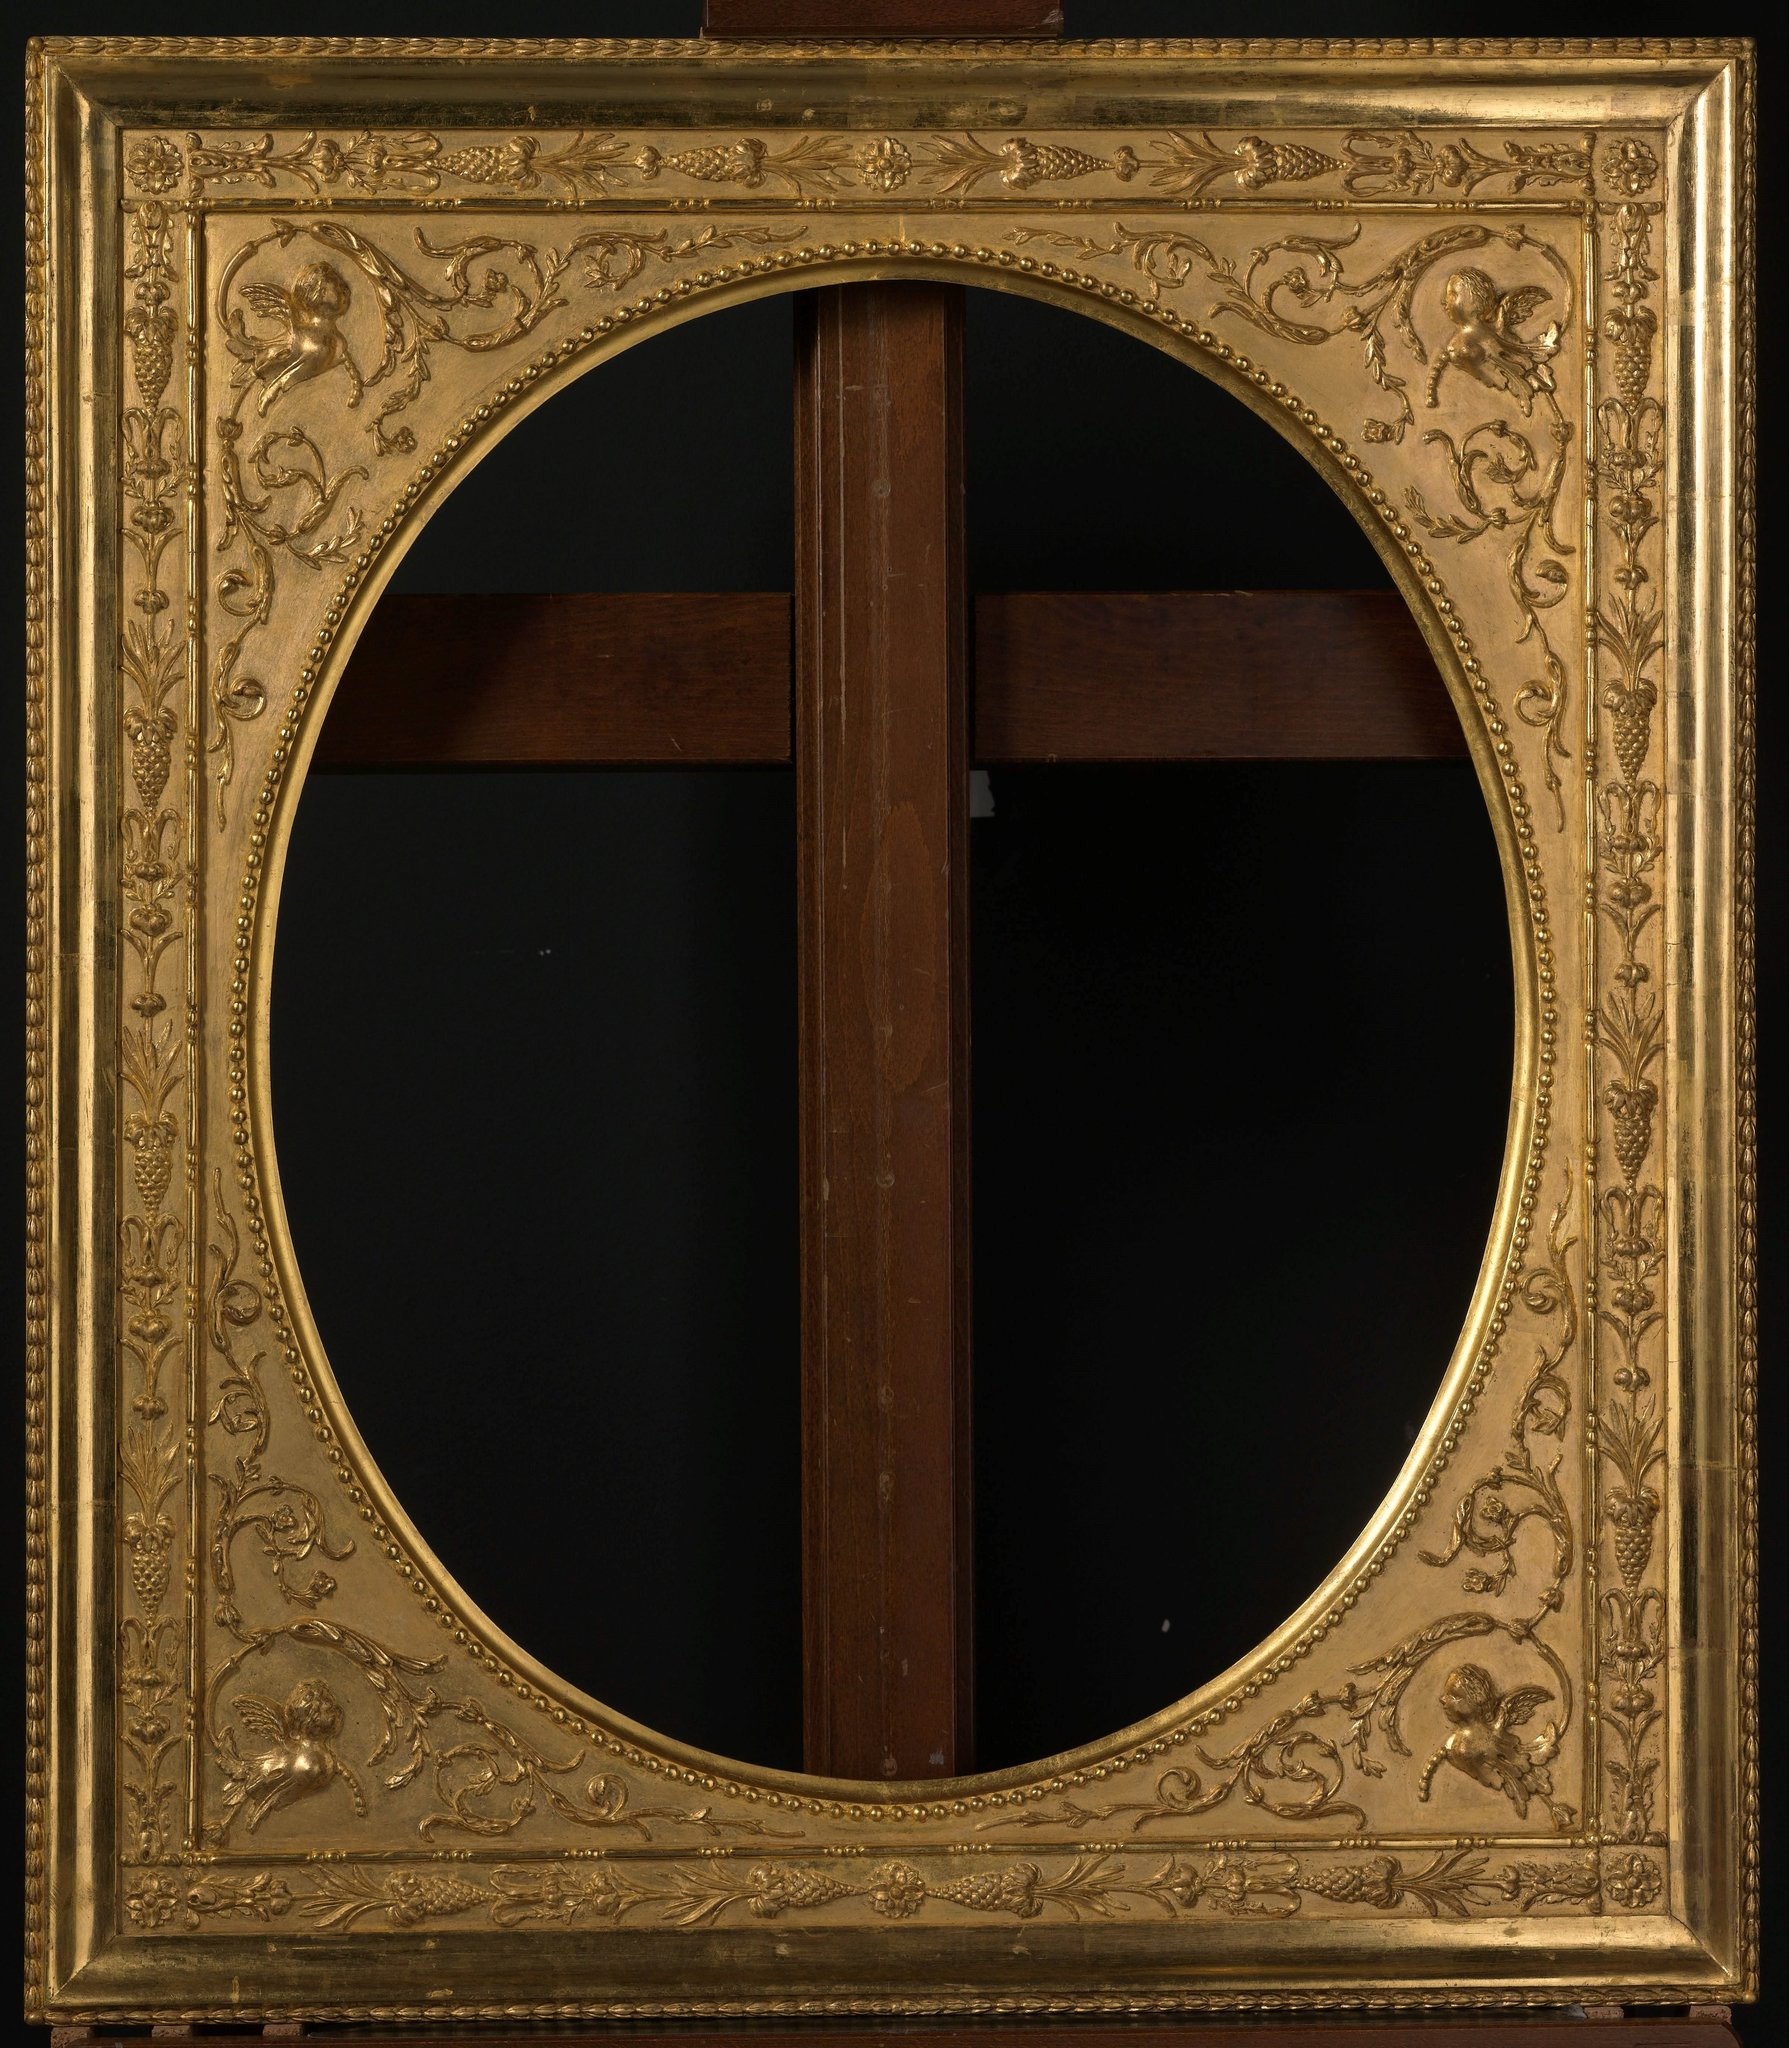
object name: frame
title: Schilderijlijst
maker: hendrik ebbens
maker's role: lijstenmaker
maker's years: 1726-1807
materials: wood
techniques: gilding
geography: the hague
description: Rechthoekig verguld kader waarin een ovaal is uitgespaard. Gedecoreerd met florale motieven, de vier hoeken versierd met arabesken die eindigen in gevleugelde sfinxen. Langs de ovale dagmaat een parelrand.